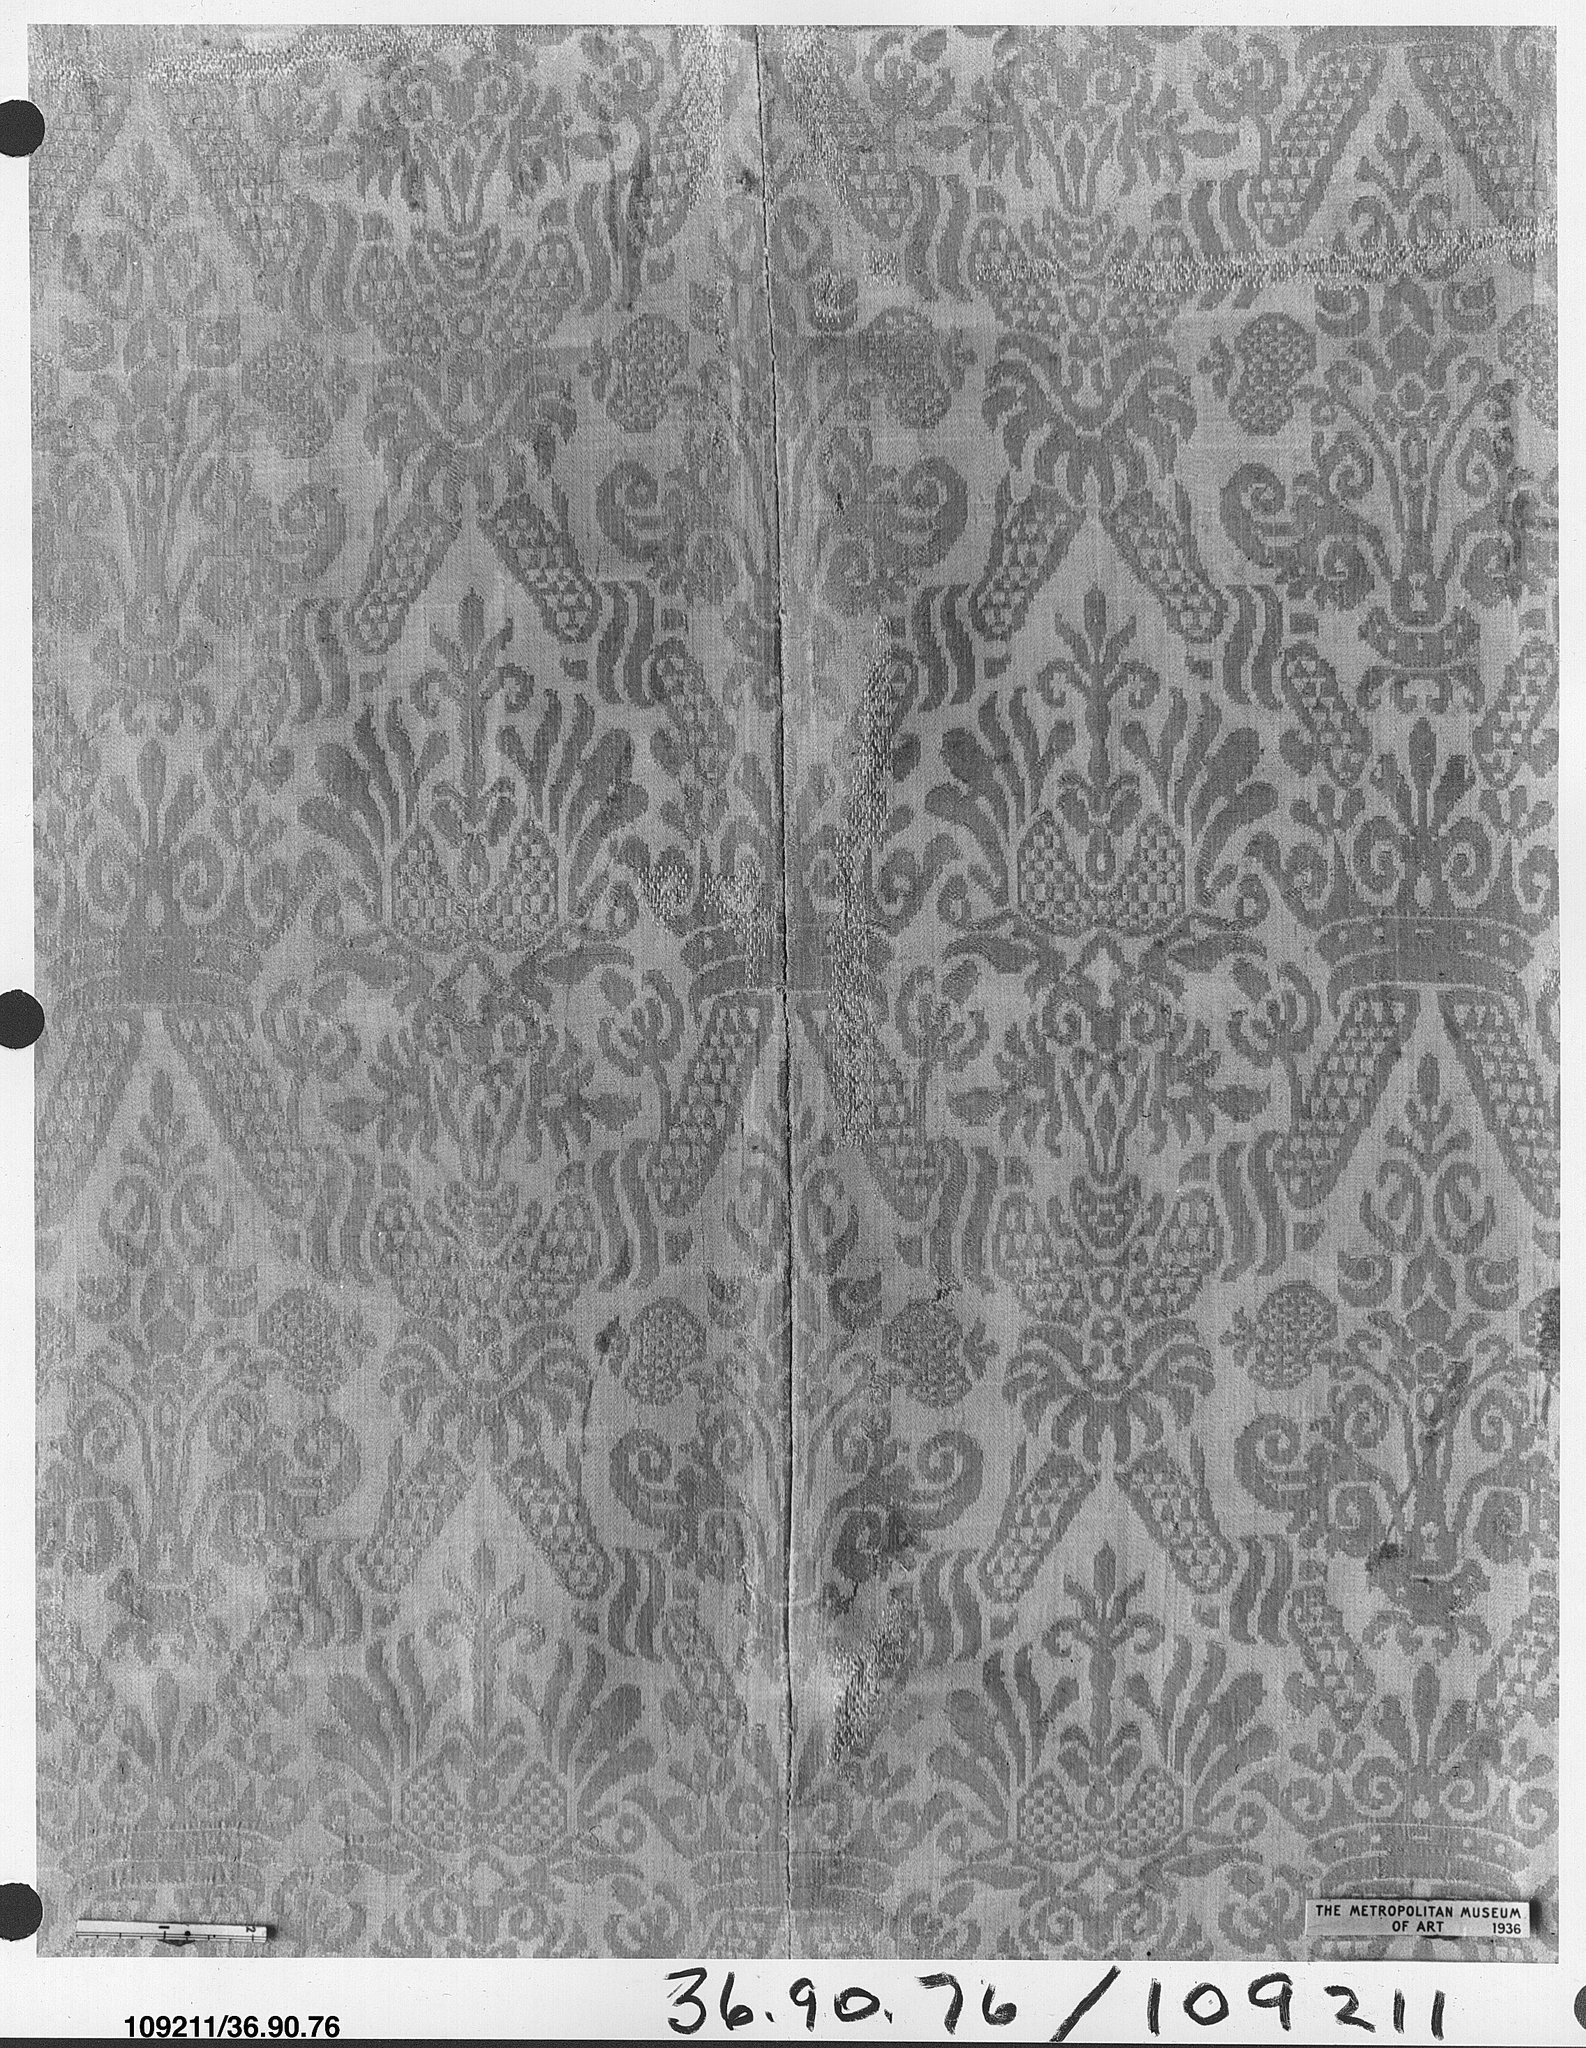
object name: piece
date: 1501-1600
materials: silk